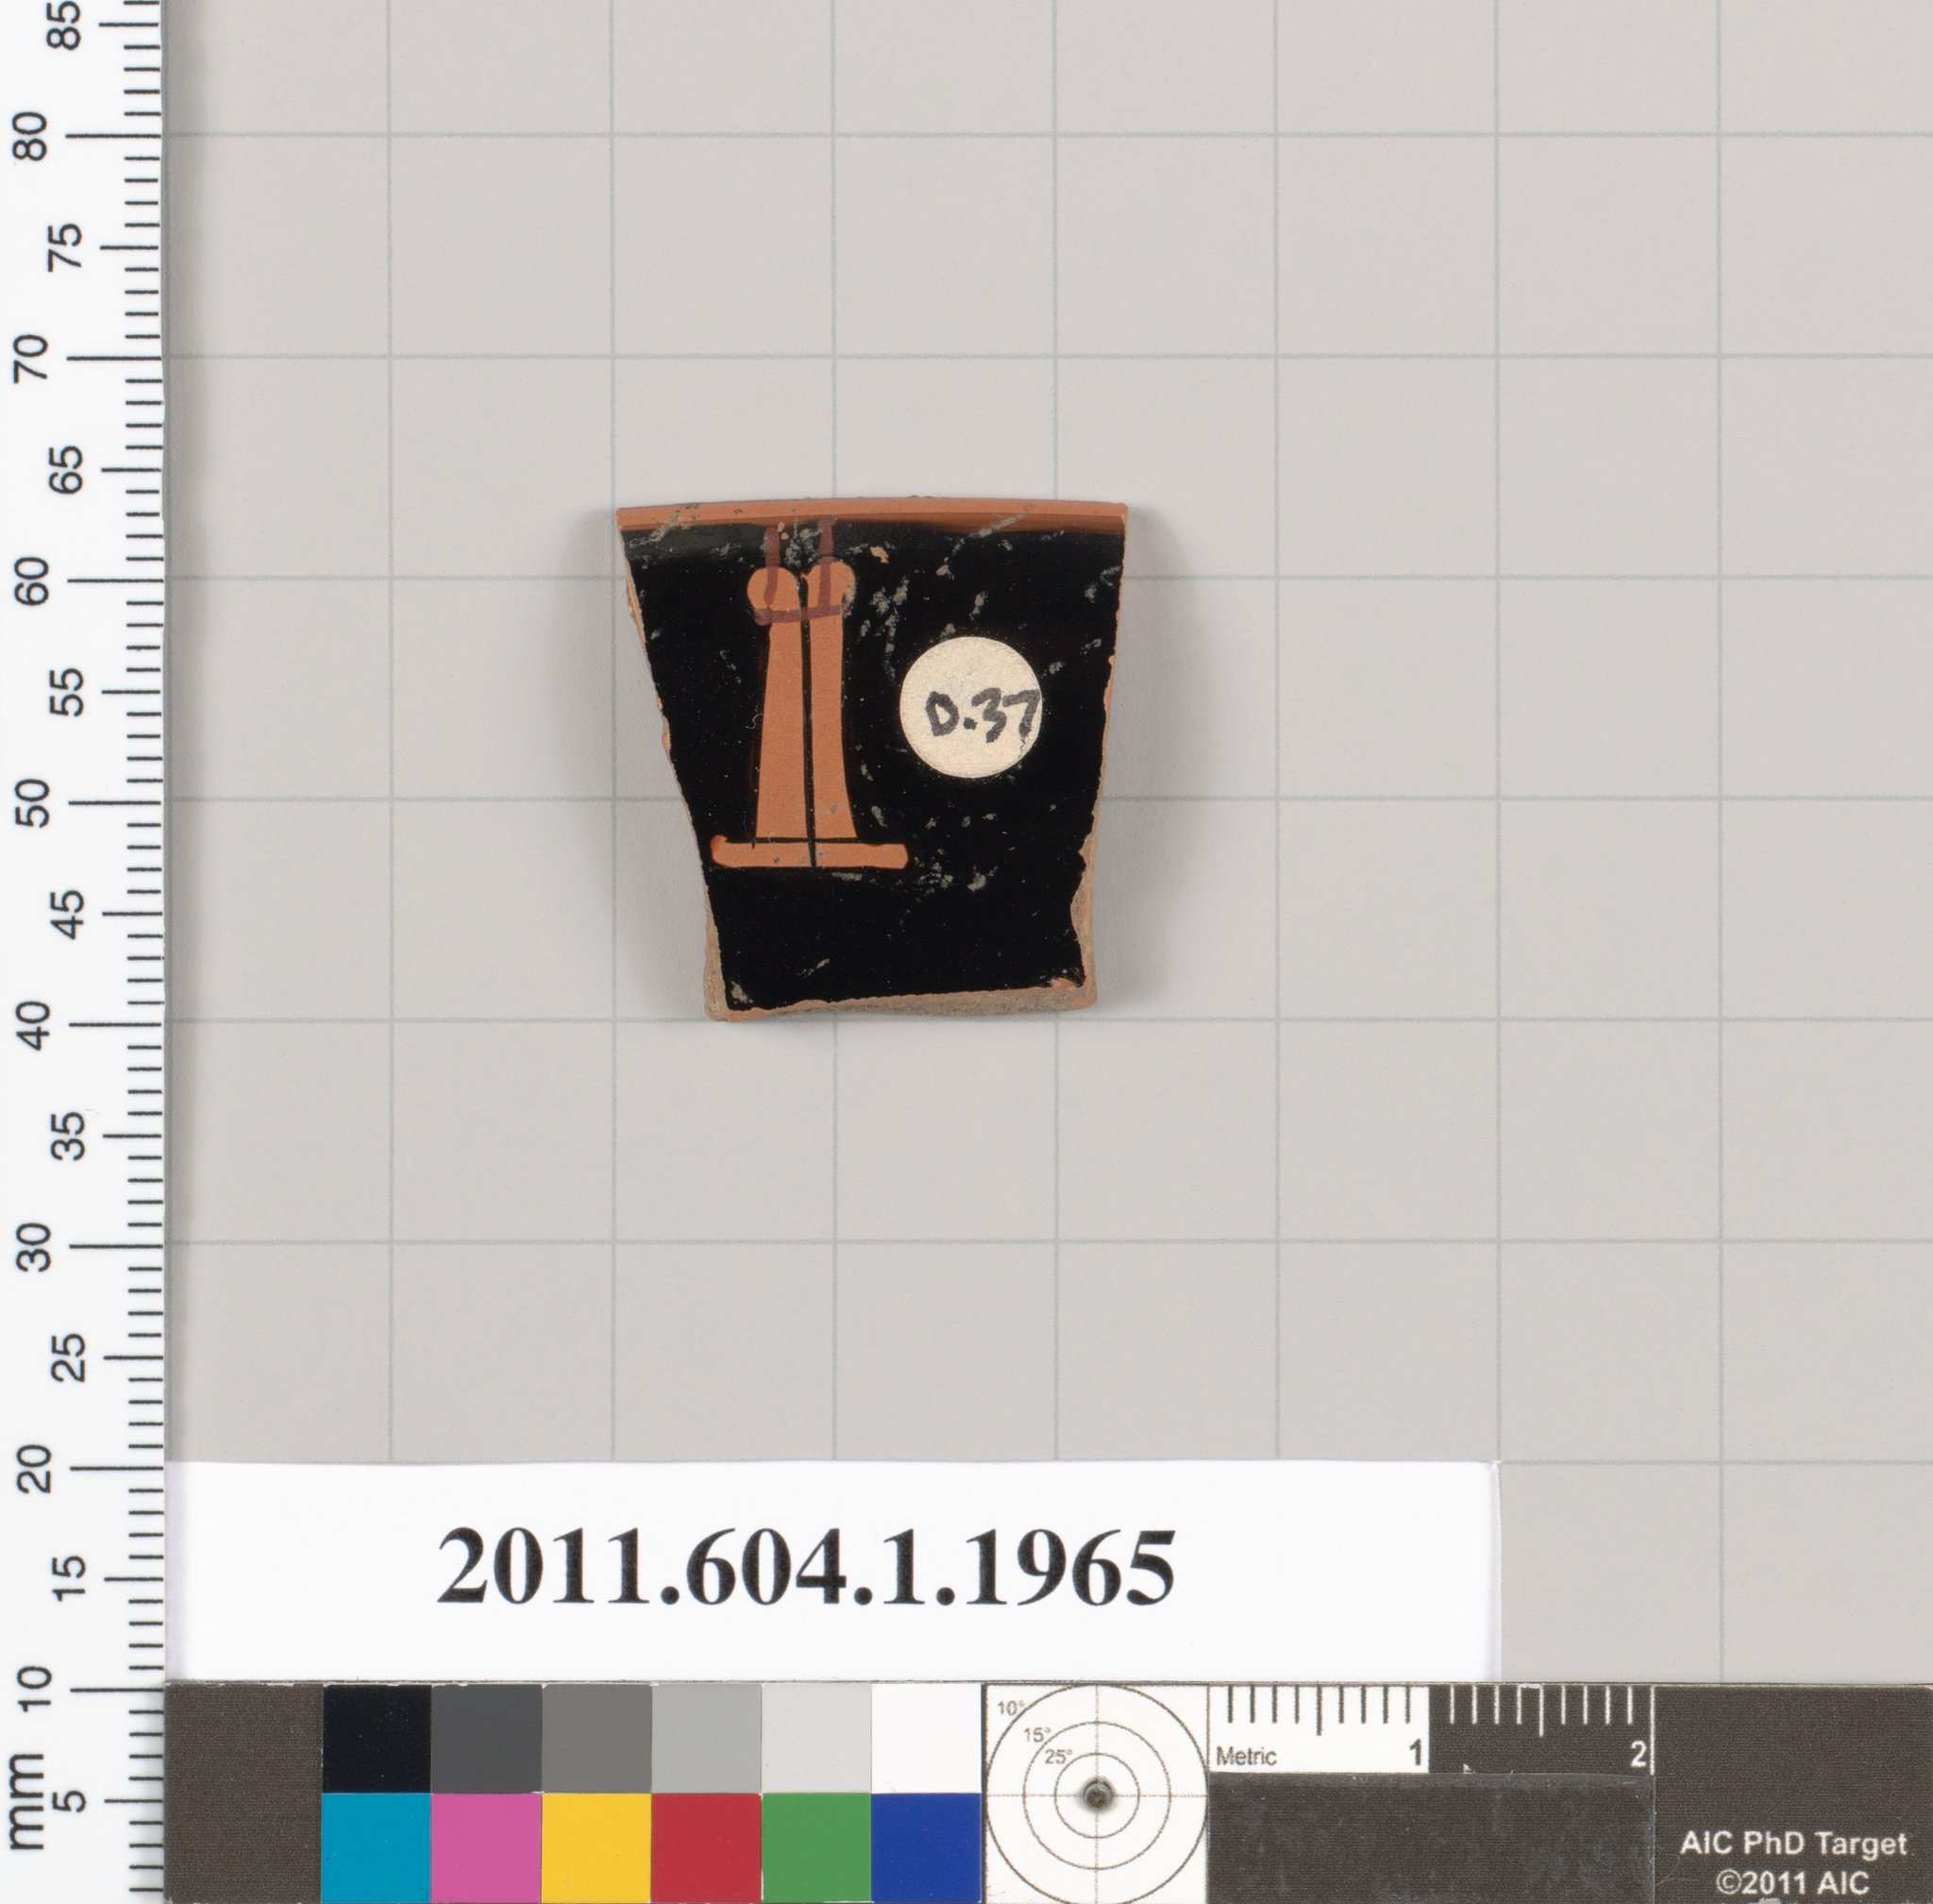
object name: kylix fragment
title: Terracotta rim fragment of a kylix (drinking cup)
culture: greek, attic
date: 490-480 BCE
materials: terracotta